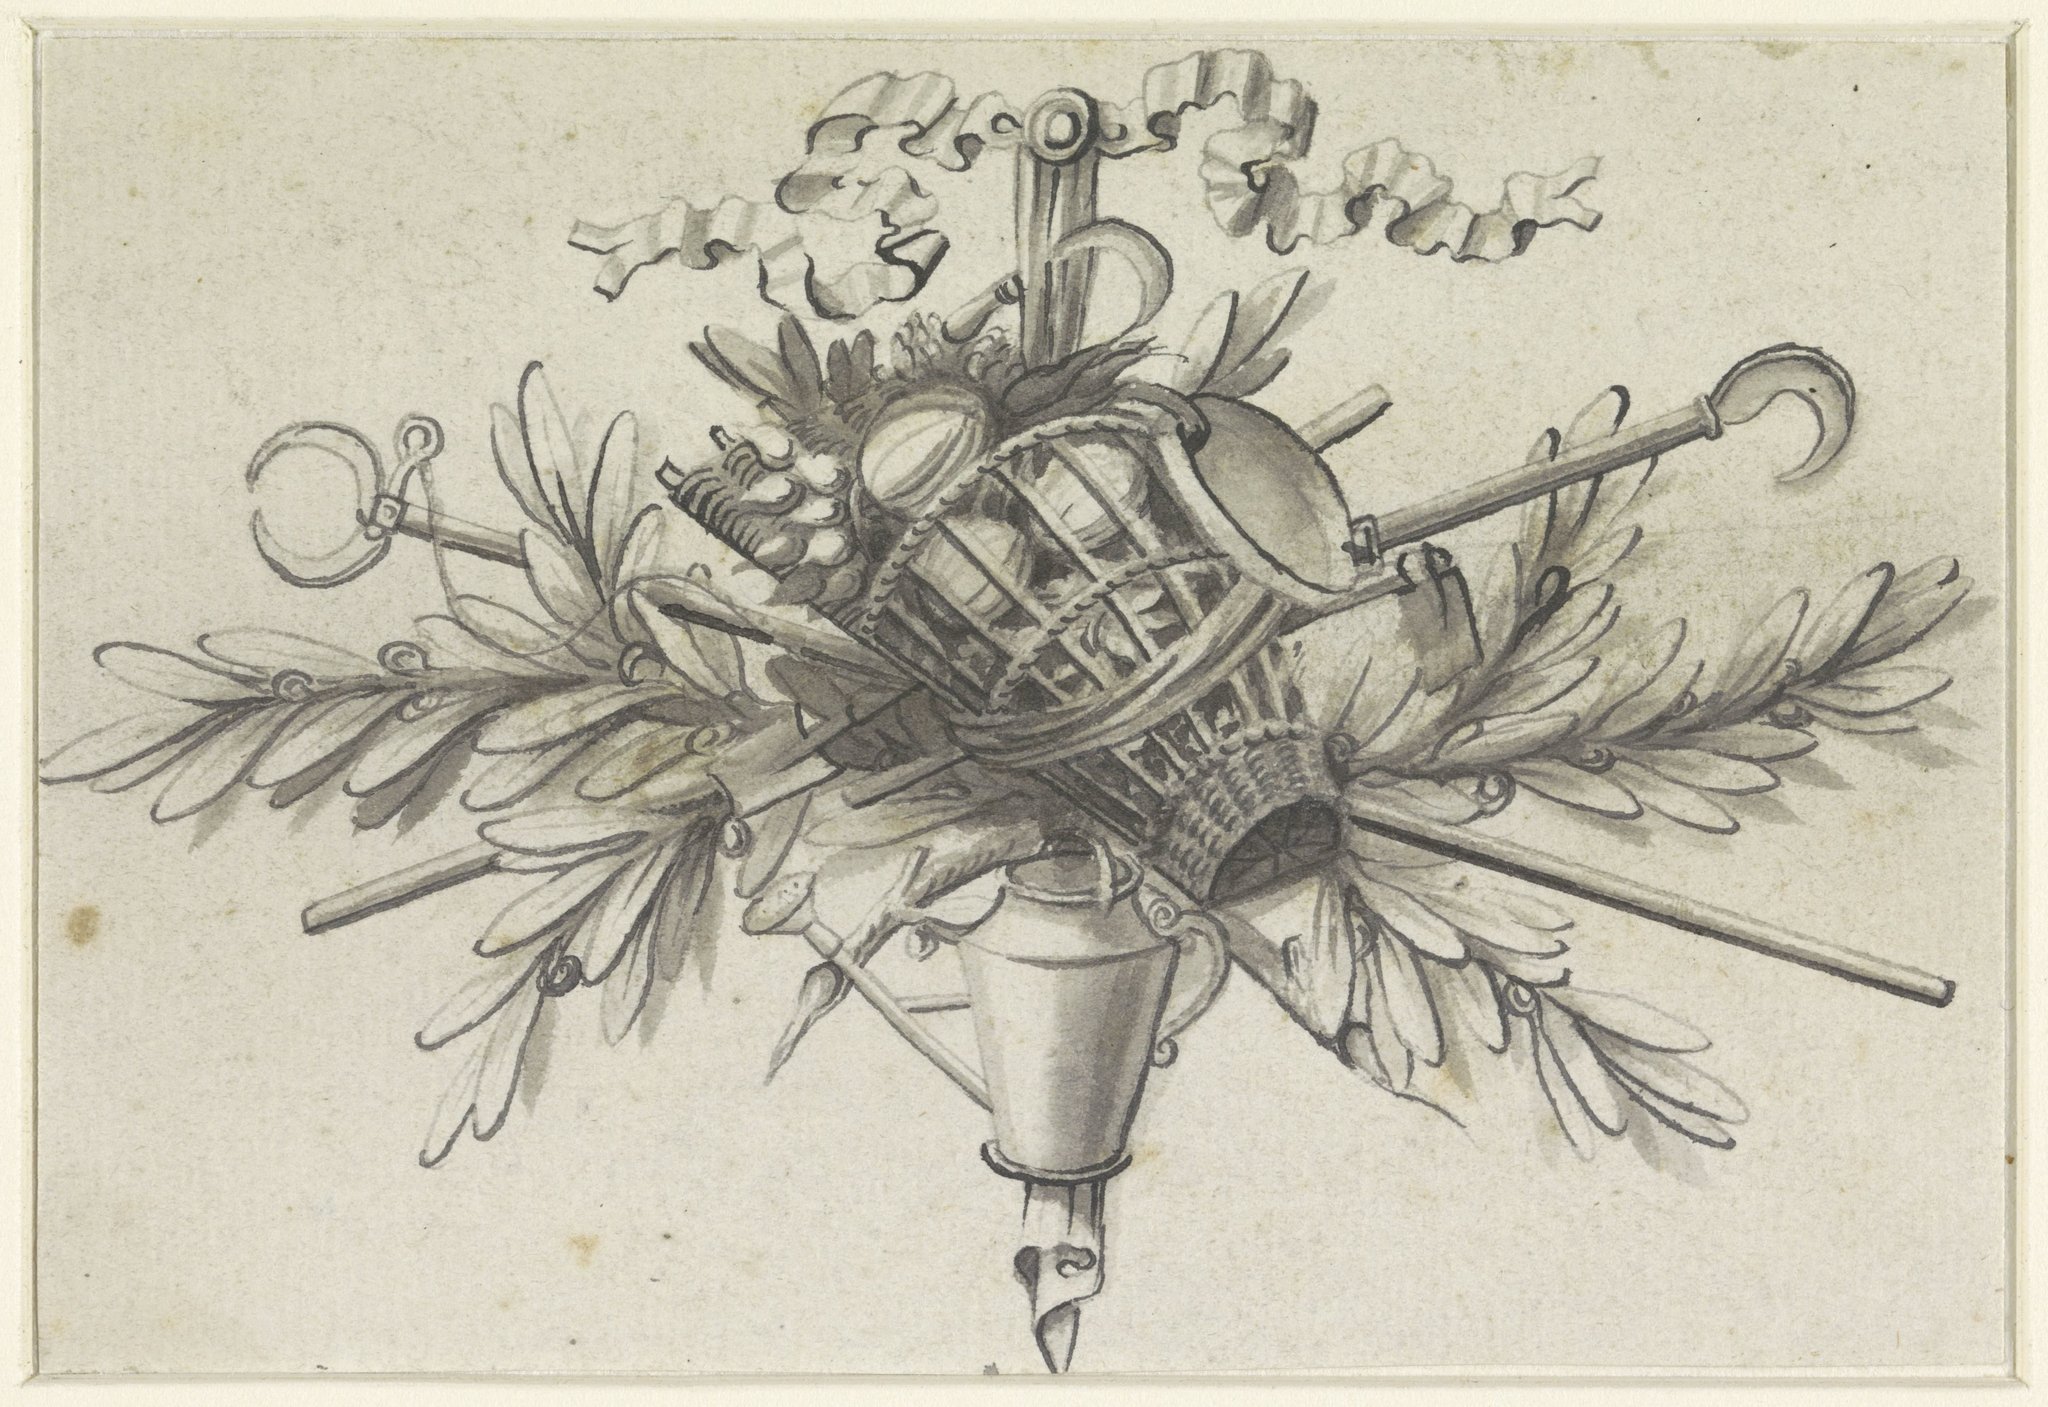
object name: drawing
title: Trofee met tuinbouwgereedschappen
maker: Anonymous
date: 1700-1800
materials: ink, paper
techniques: brush, pen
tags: trophy, i.e.: decorative arrangement of symbolic or typical objects ~ ornament, gardening-tools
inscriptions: collector's mark: Lugt 2228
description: Een trofee met bladmotieven en tuinbouwgereedschappen zoals een gieter, een mand met fruit en sikkels.